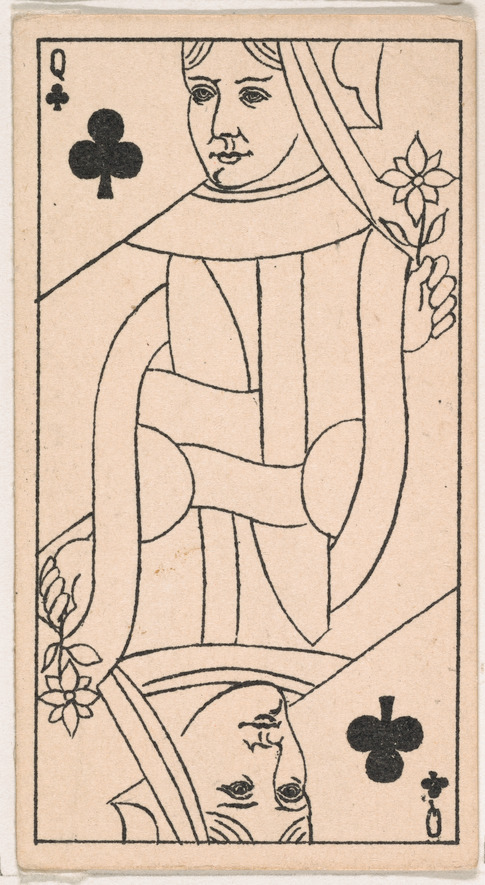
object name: print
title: Queen of Clubs, from the Transparent Playing Cards series (N220) issued by Kinney Bros.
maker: kinney brothers tobacco company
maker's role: publisher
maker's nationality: american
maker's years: 1869-2011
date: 1888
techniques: color lithograph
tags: queens,playing cards